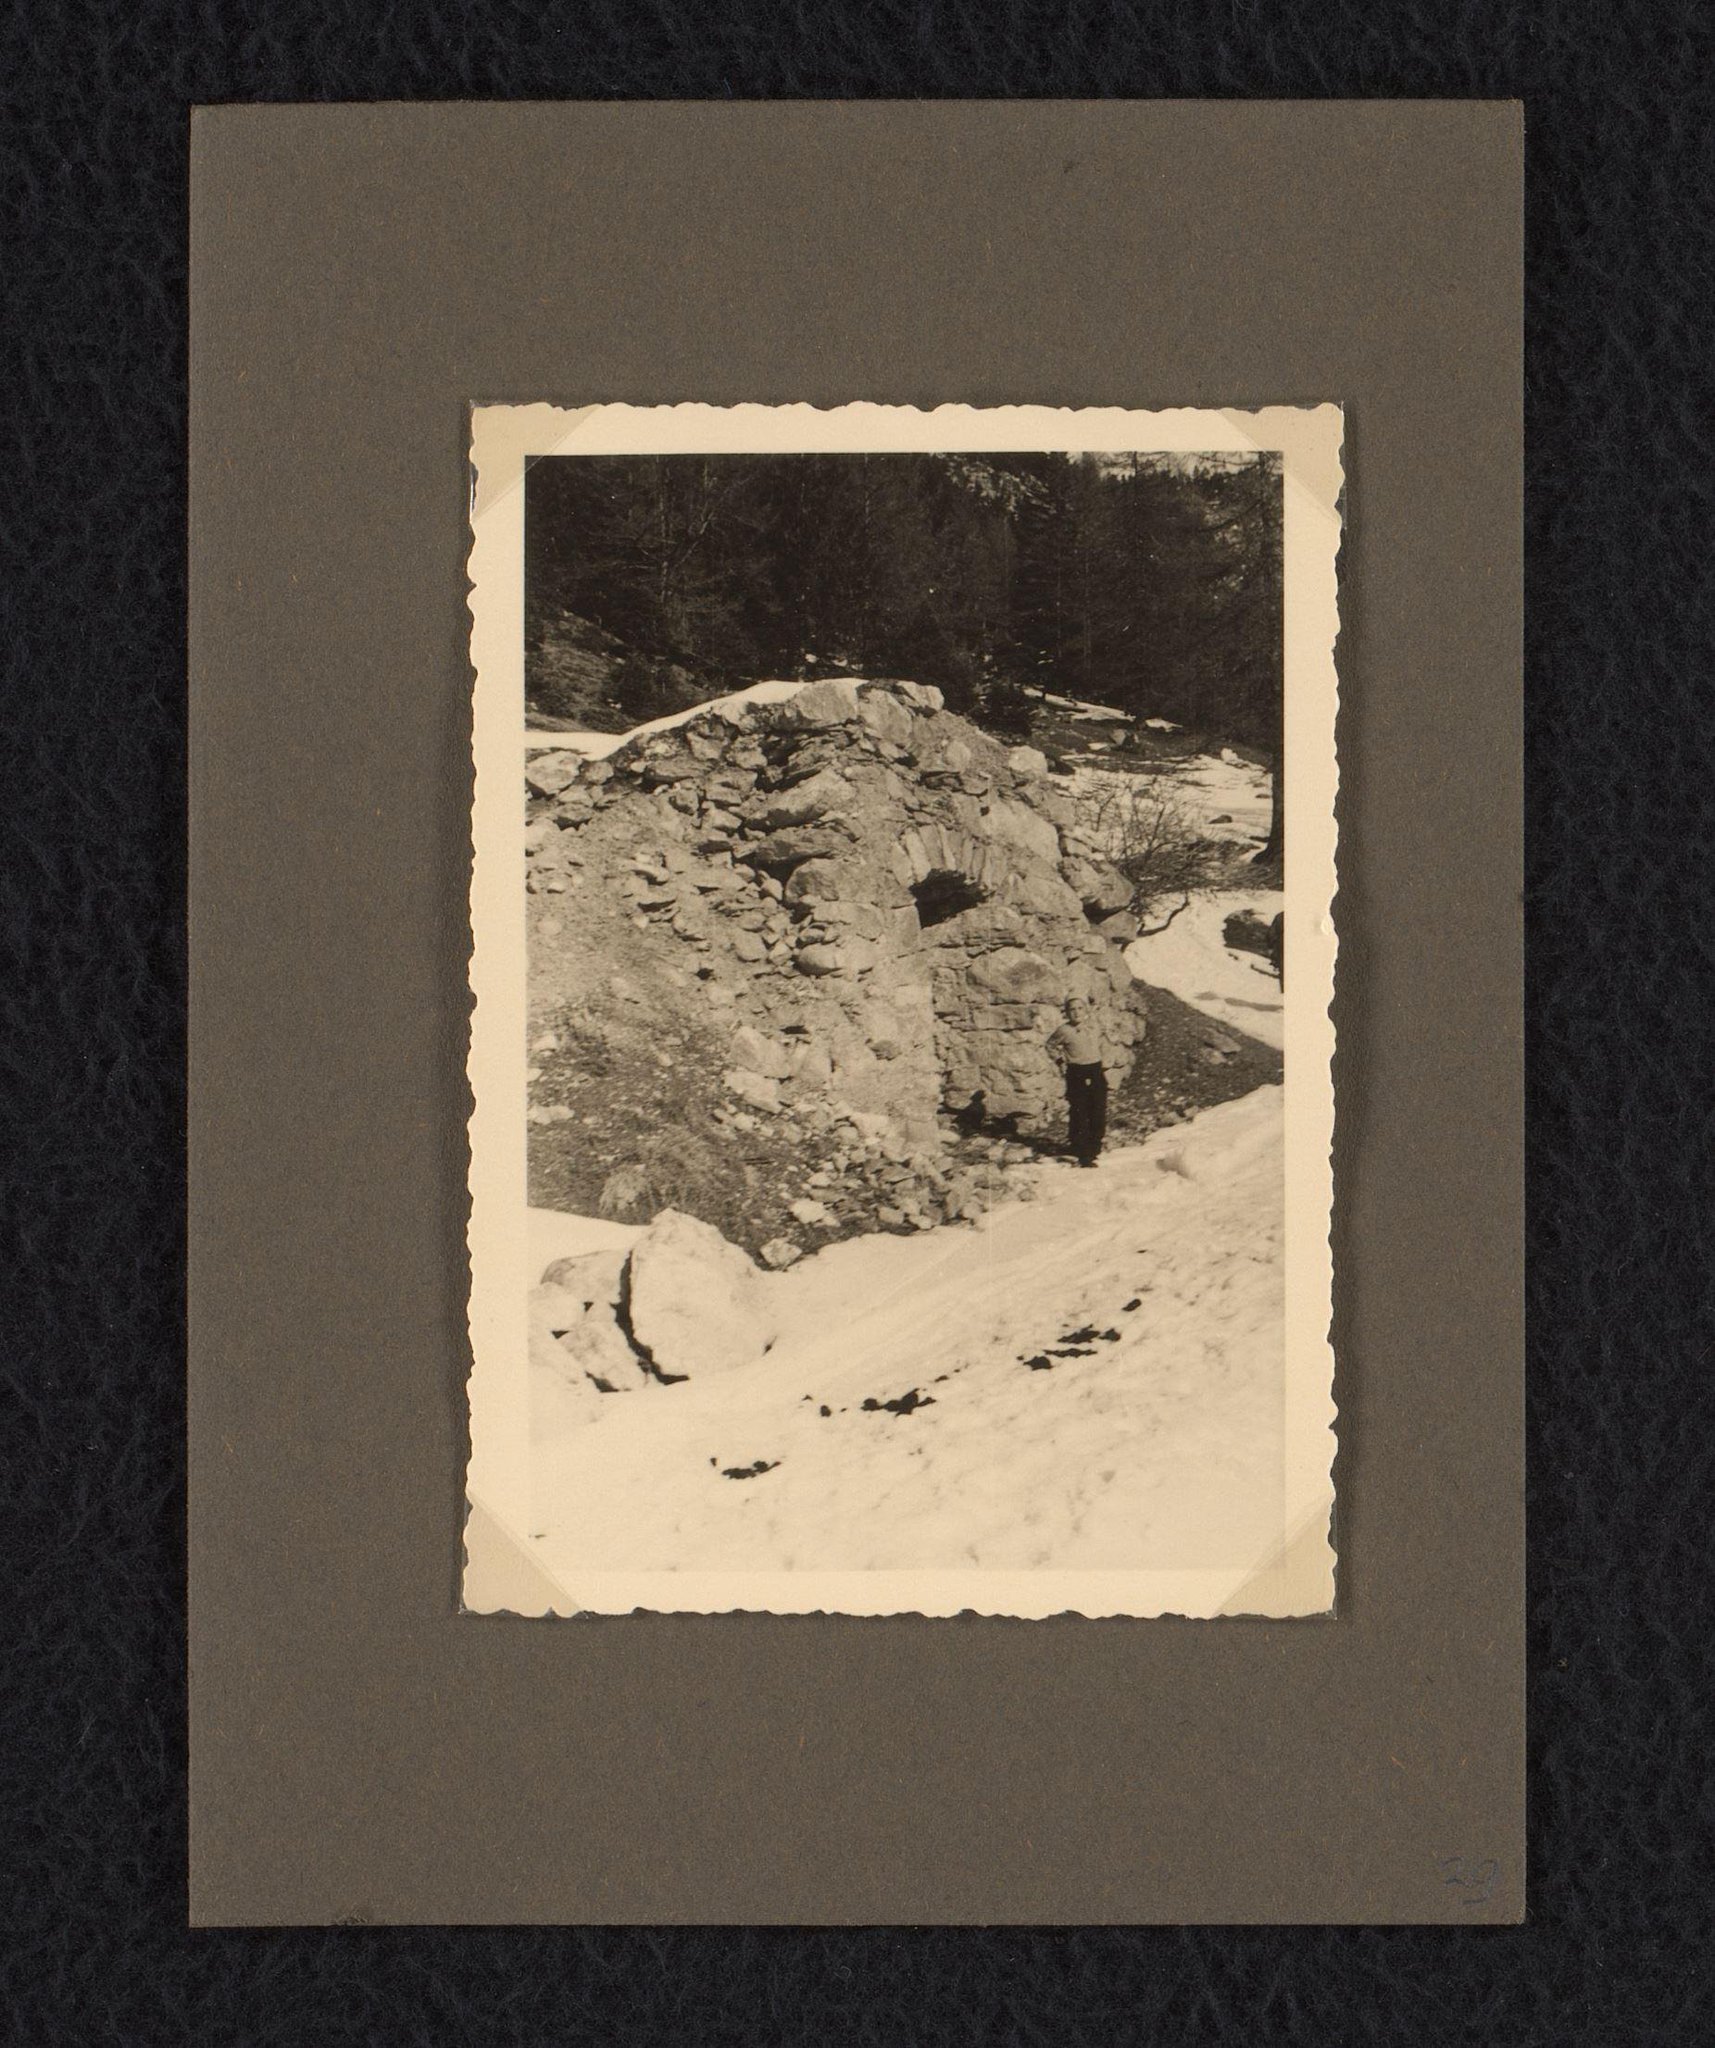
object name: photograph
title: Isabel bij een stenen poort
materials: cardboard, photographic support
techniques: gelatin silver print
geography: lenzerheide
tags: leiden, isabel wachenheimer-elon, the family travelling, on holiday, snow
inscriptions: date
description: Albumblad met een foto van Isabel Wachenheimer staande bij een stenen poort. Onderdeel van het fotoalbum met vakantiefoto's Lenzerheide, 1934.